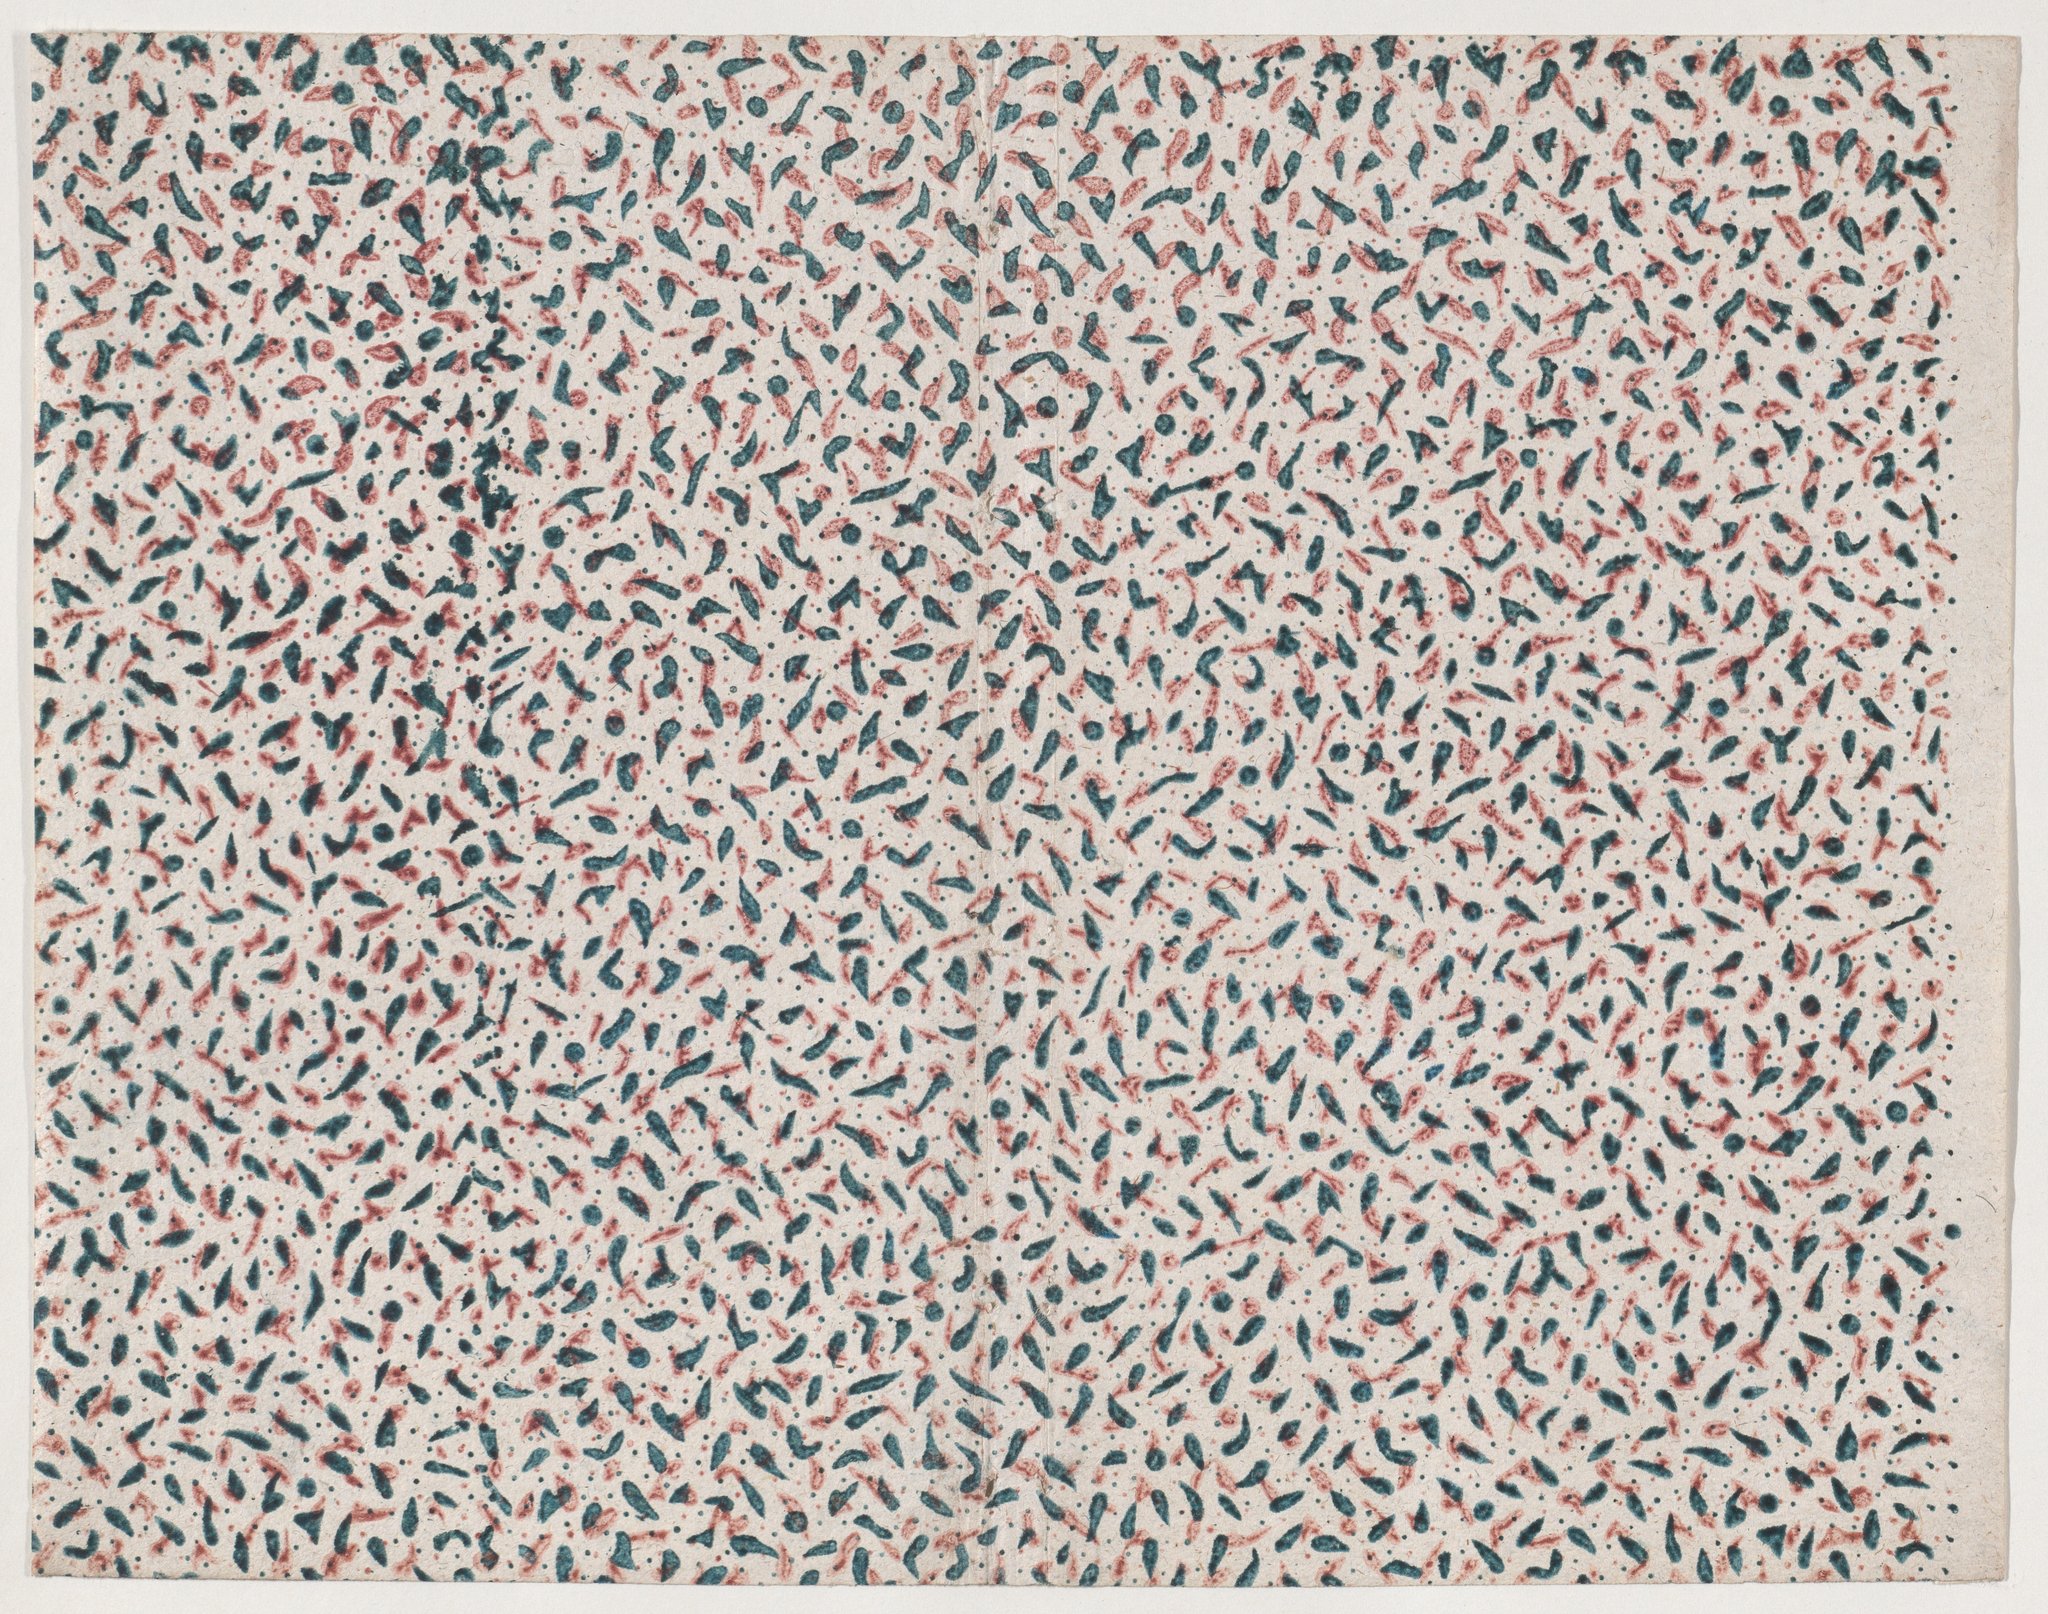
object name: print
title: Sheet with overall abstract pattern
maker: Anonymous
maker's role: artist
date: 1801-1900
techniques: relief print